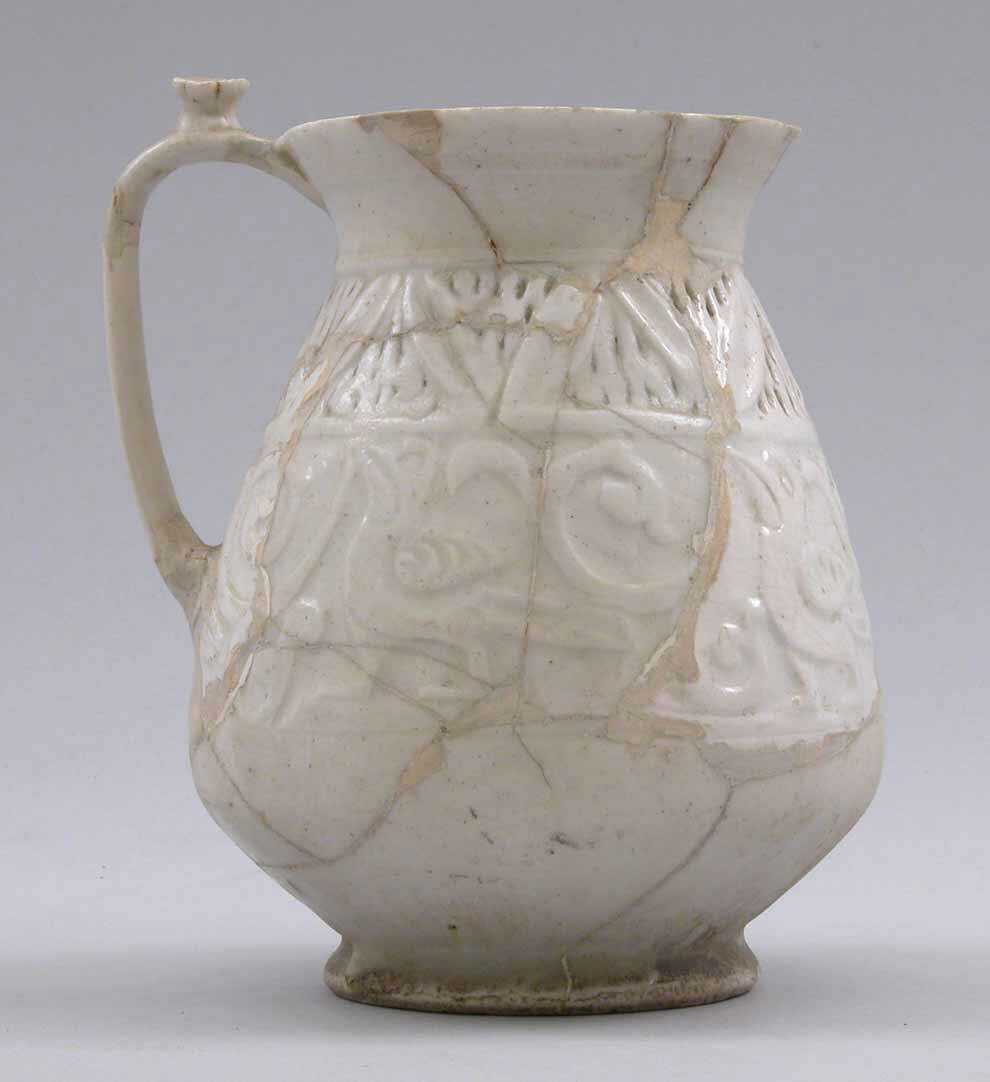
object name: ewer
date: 901-1100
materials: earthenware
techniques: glazing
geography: iran